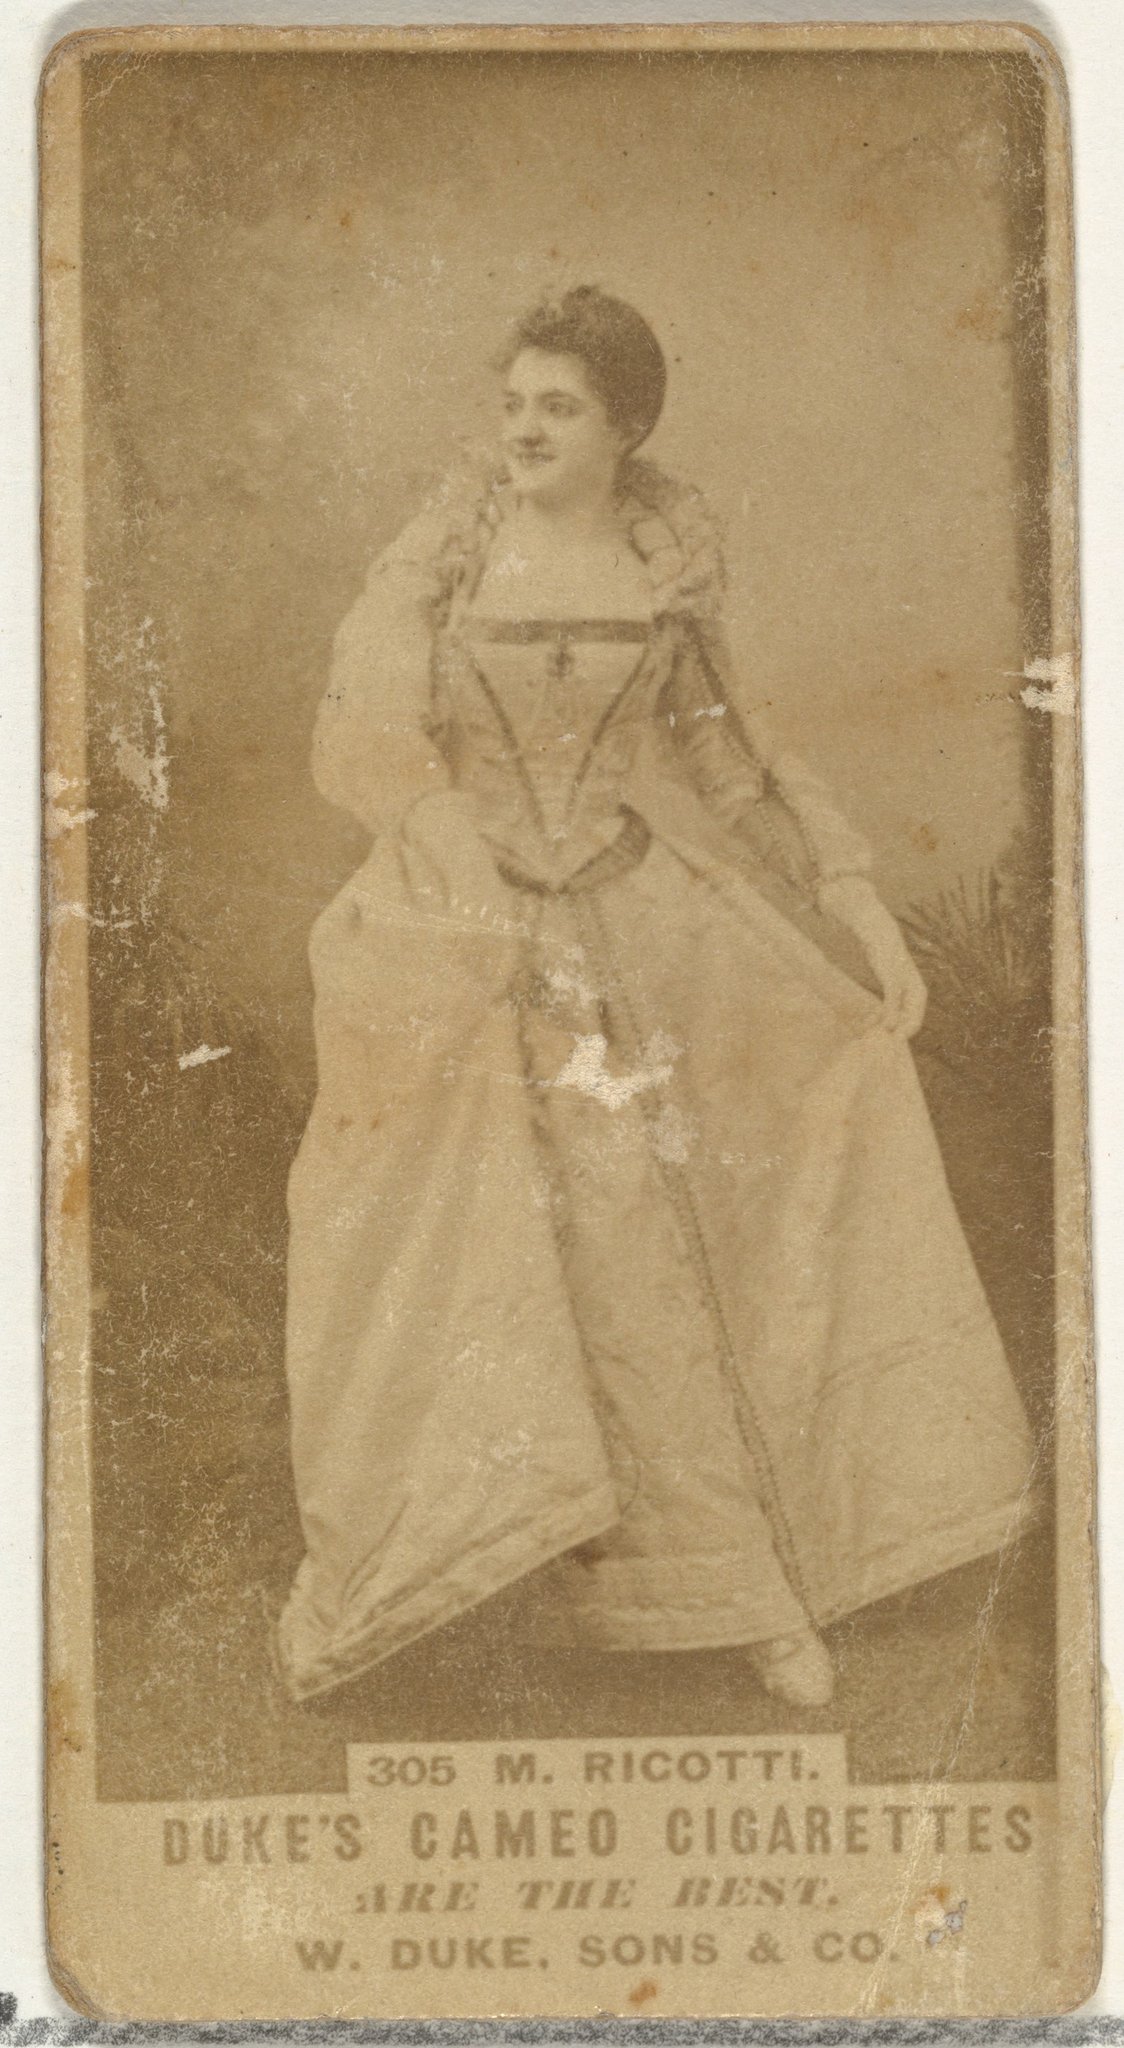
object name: photograph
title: Card Number 305, M. Ricotti, from the Actors and Actresses series (N145-5) issued by Duke Sons & Co. to promote Cameo Cigarettes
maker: w. duke, sons & co.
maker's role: publisher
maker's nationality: american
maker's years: 1870-1920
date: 1880-1889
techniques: albumen silver print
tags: portraits,women,actresses